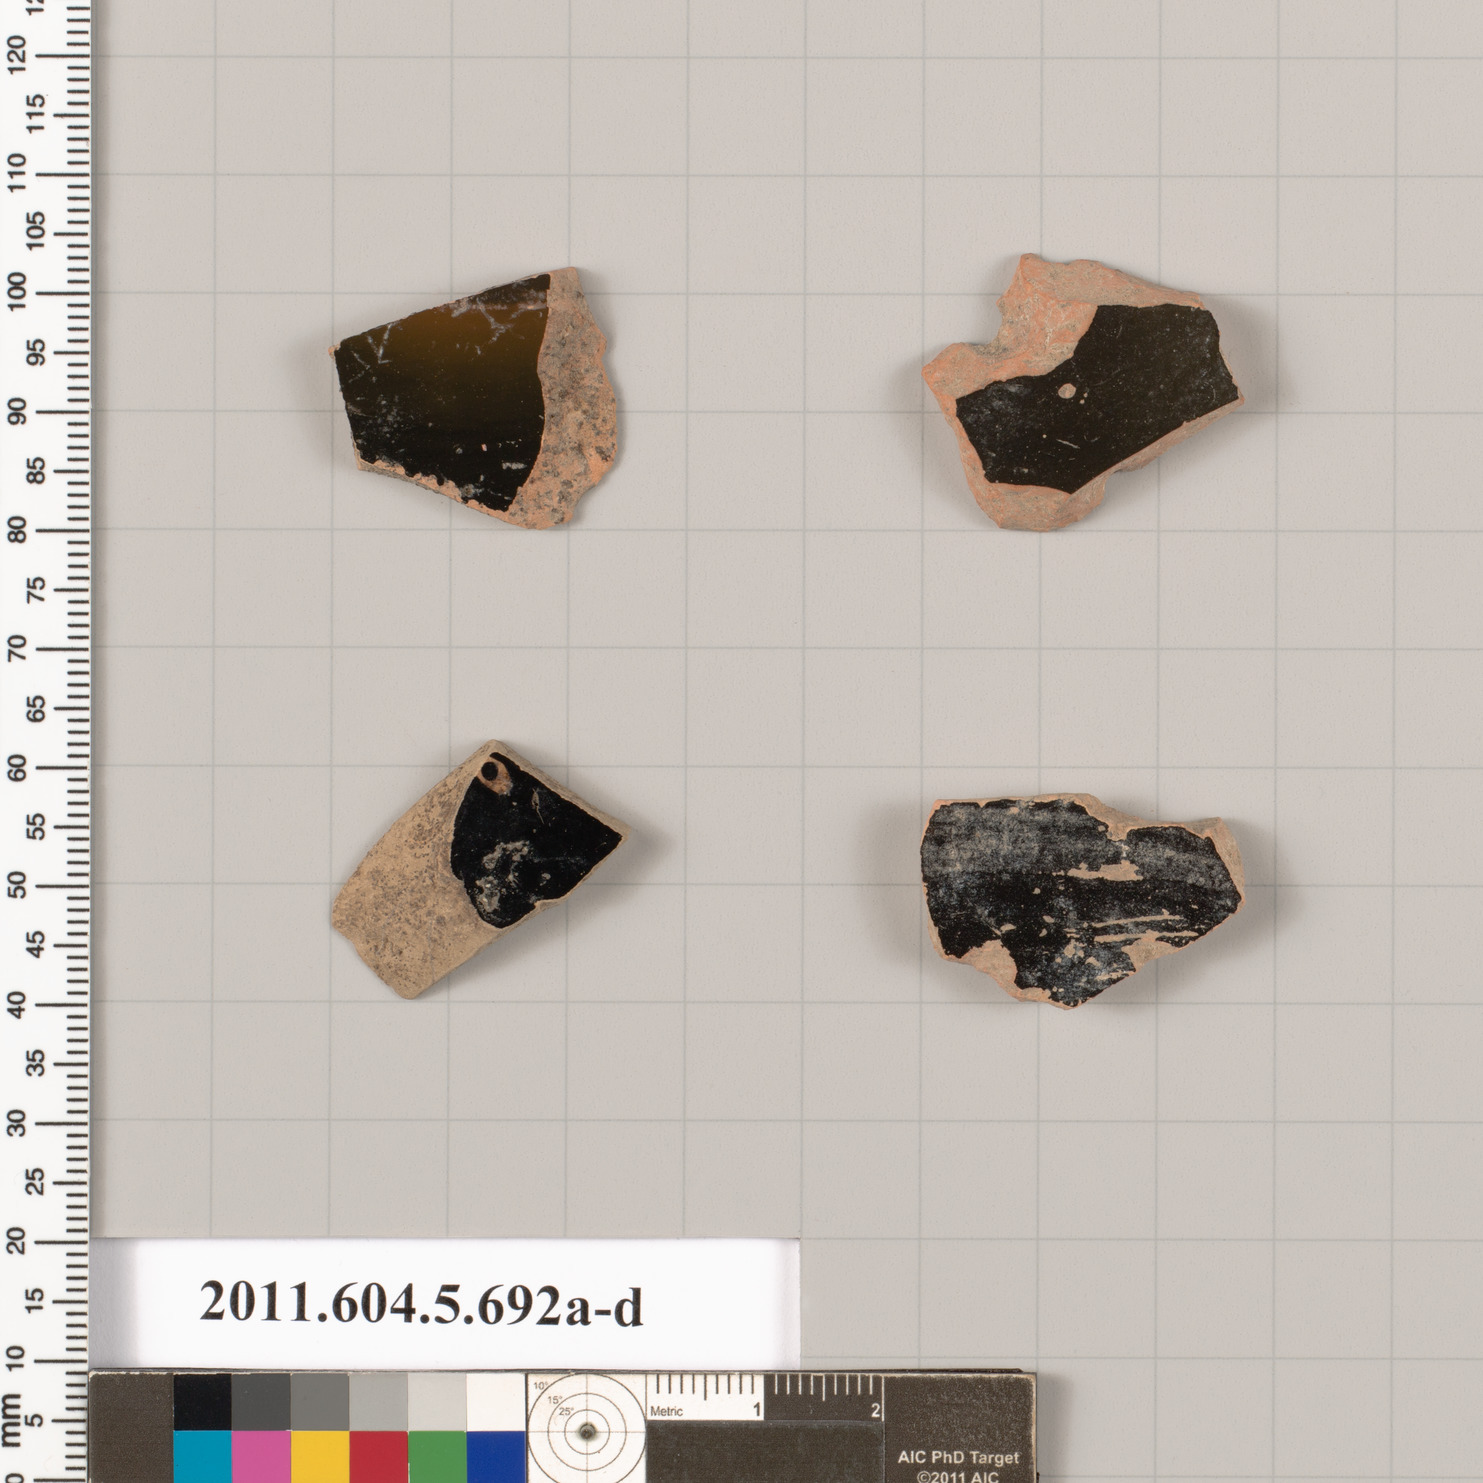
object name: kylix fragment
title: Terracotta fragments of kylikes (drinking cups)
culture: greek, attic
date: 600-401 BCE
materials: terracotta